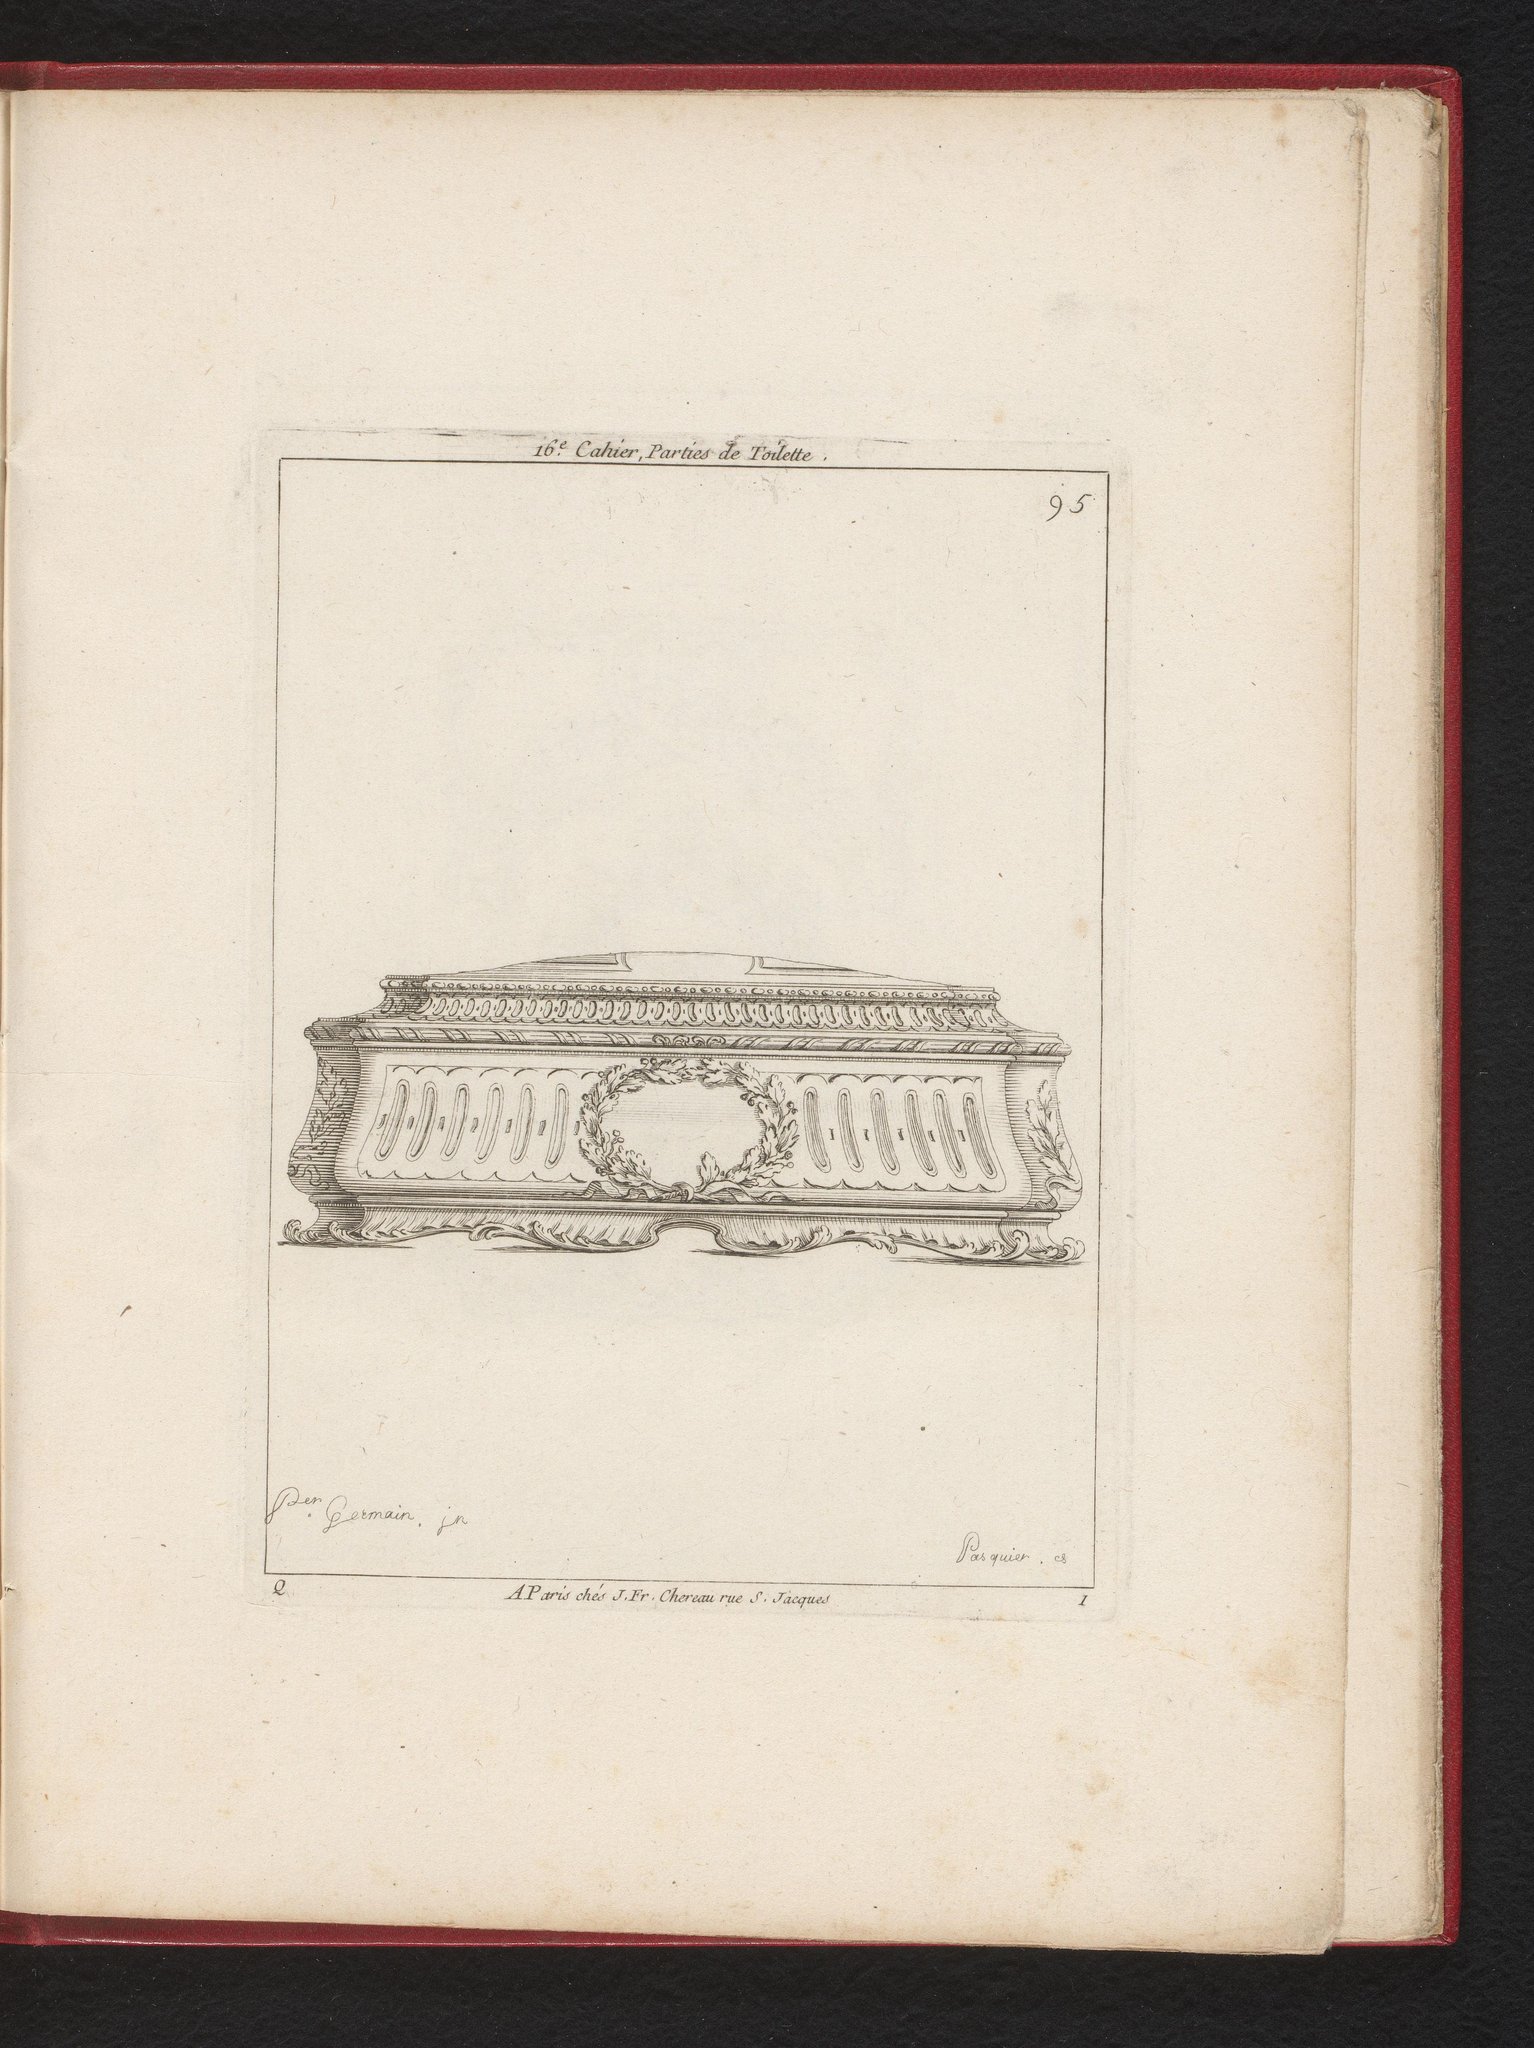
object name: print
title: Ontwerp voor een vierkante juwelendoos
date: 1748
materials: paper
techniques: etching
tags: jewel-box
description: Een aantal van de objecten in deze reeks heeft een eigen ondertitel, die verwijst naar genummerde 'cahiers' (afleveringen) waarin de prenten werden uitgegeven. Het is onduidelijk welke objecten recies bij welke aflevering horen. Daarom is die ondertitel enkel verwerkt bij de prent waarop die voorkomt.